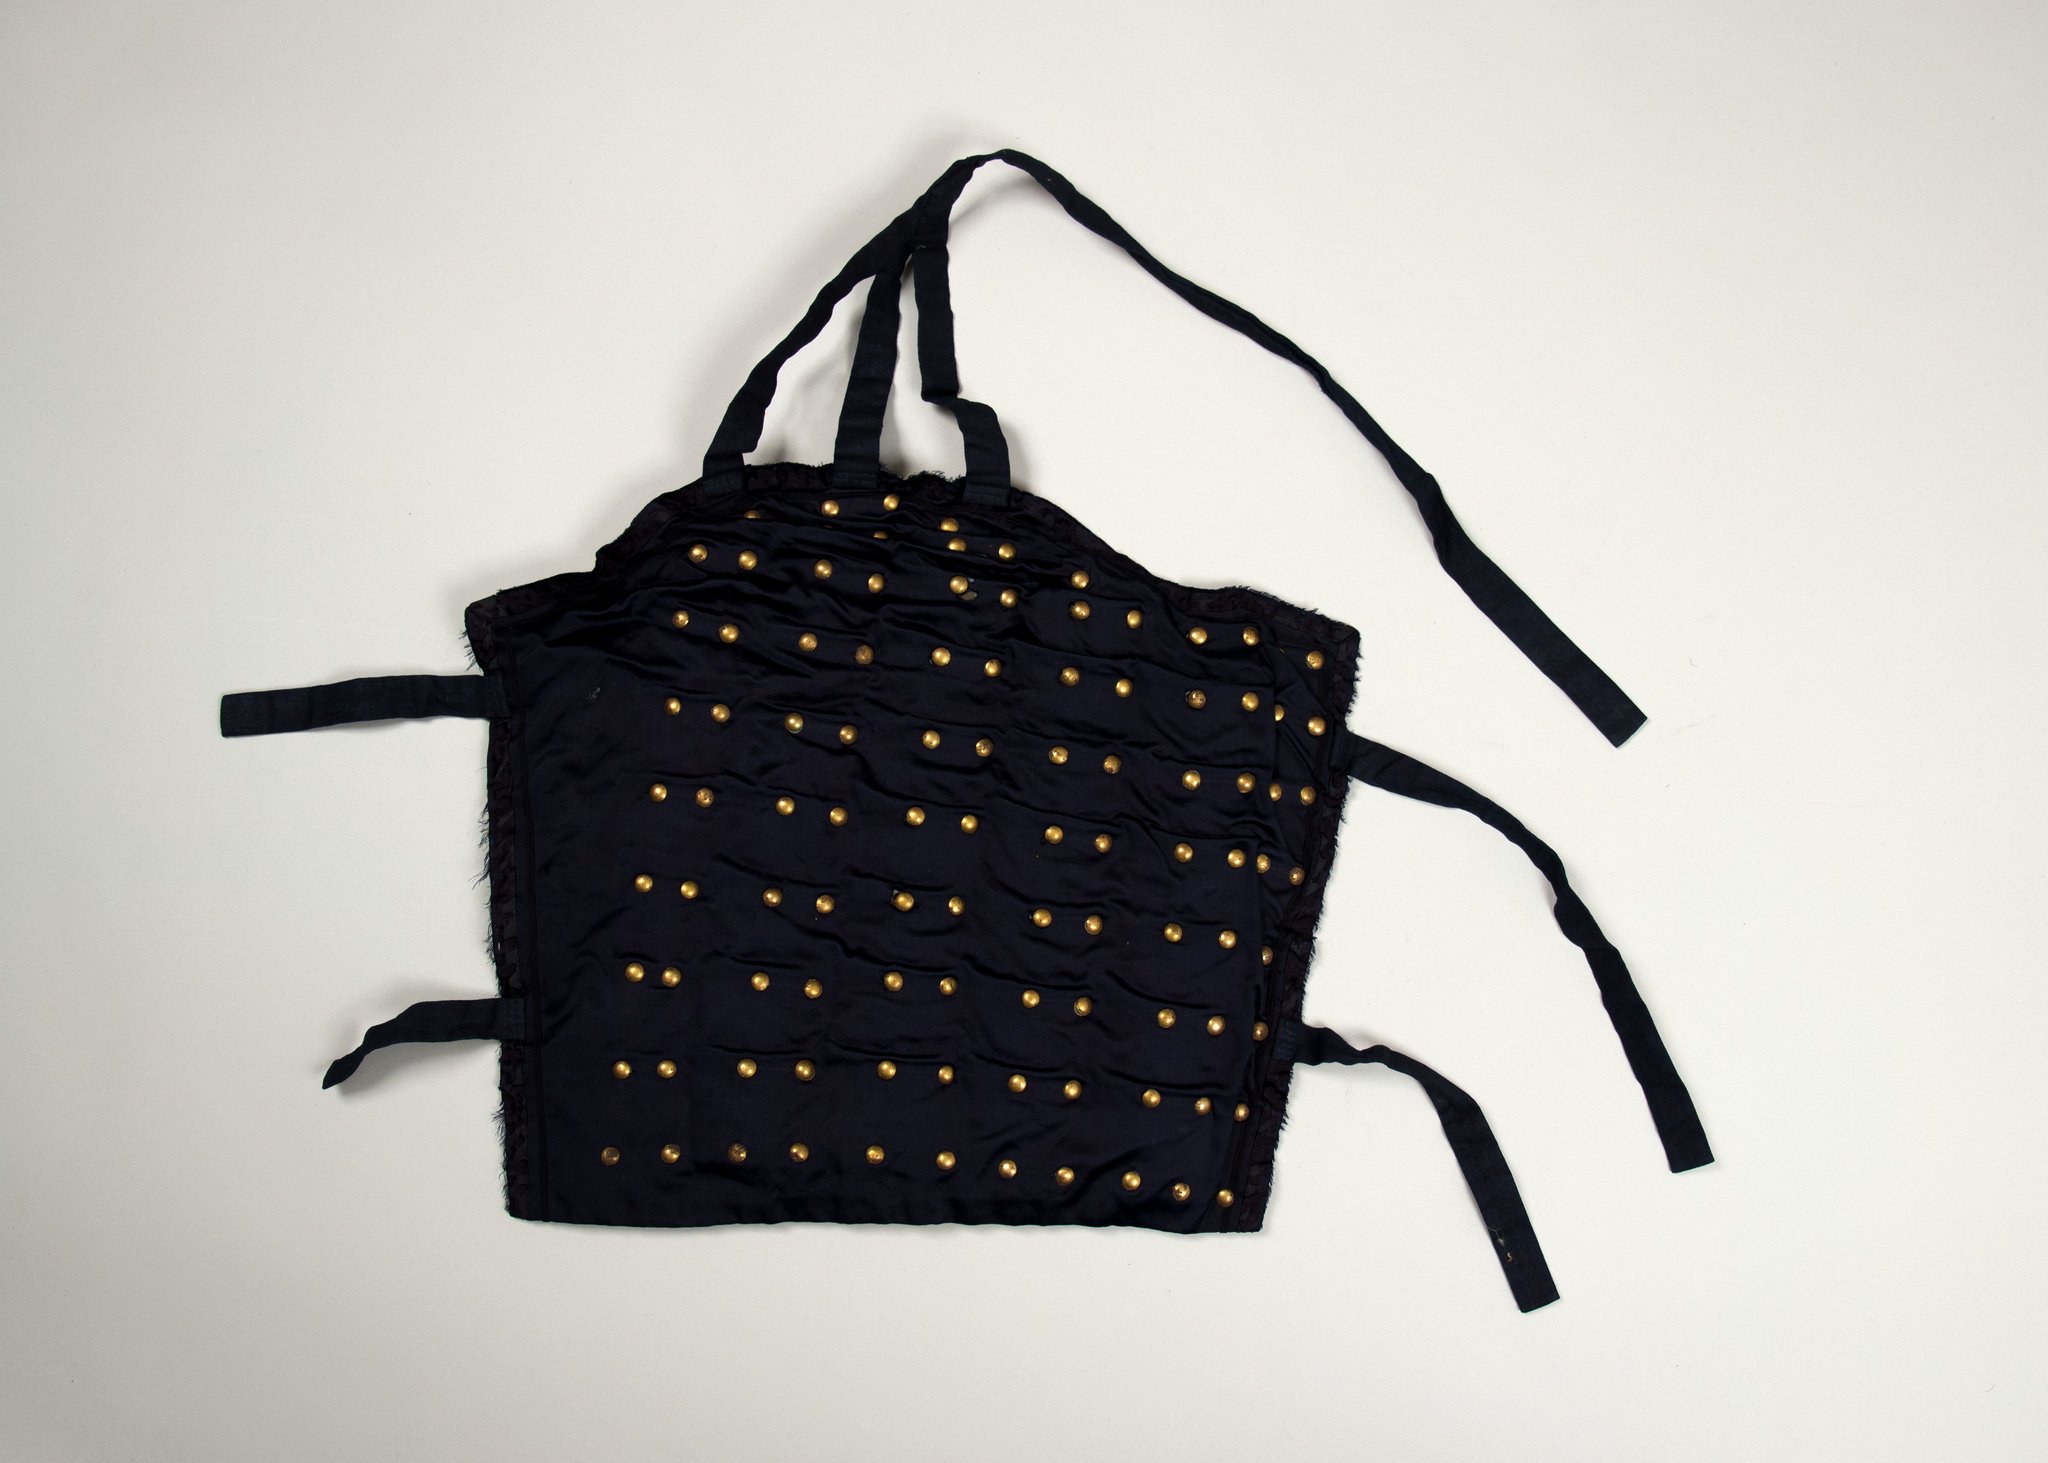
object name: brigandine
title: Four Pieces of Brigandine Armor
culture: chinese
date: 1701-1900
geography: china